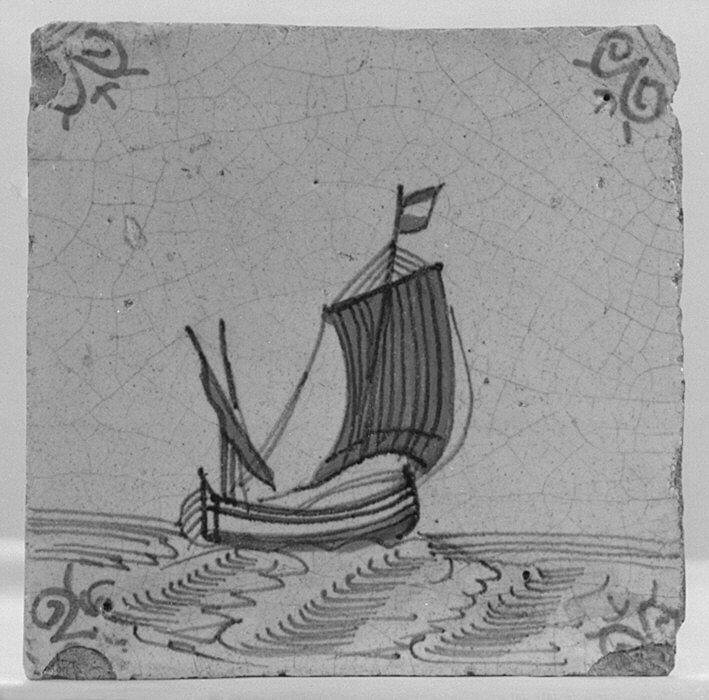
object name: tile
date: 1650-1680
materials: earthenware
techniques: glazing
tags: flags,boats